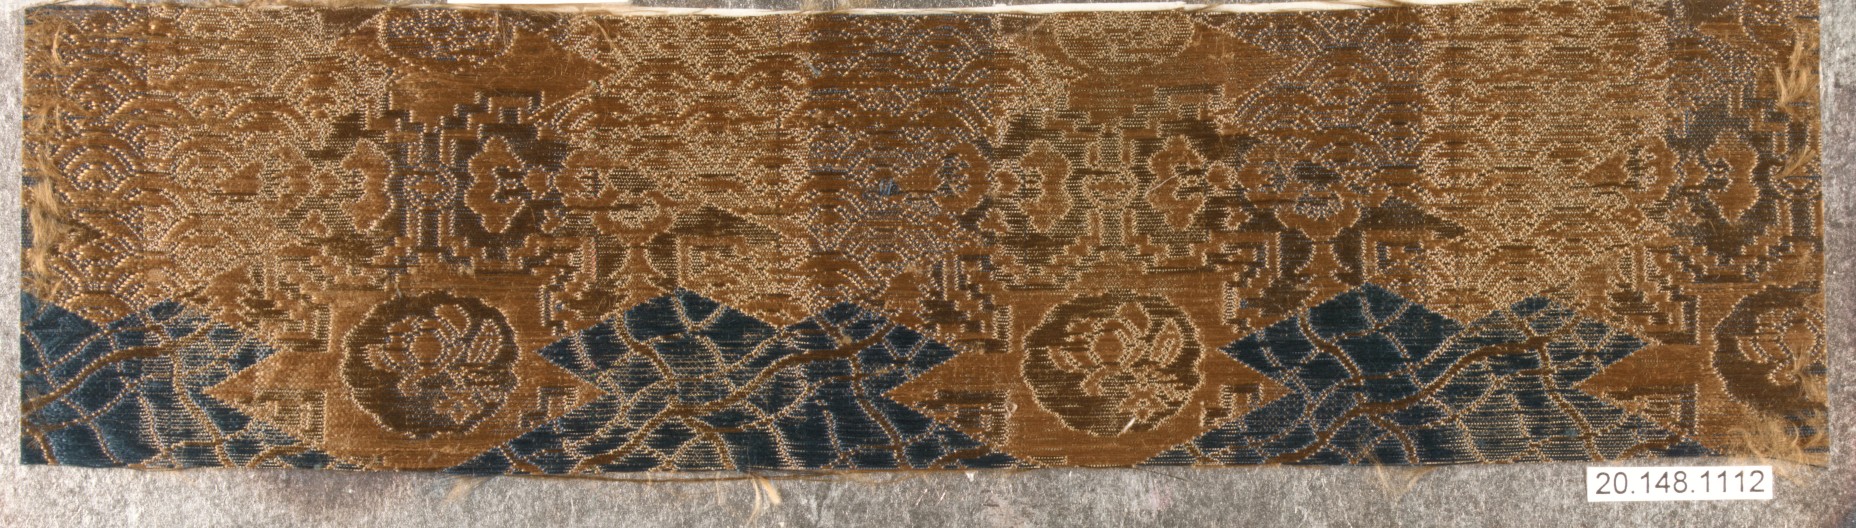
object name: piece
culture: japanese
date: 1701-1800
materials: silk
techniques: compound weave